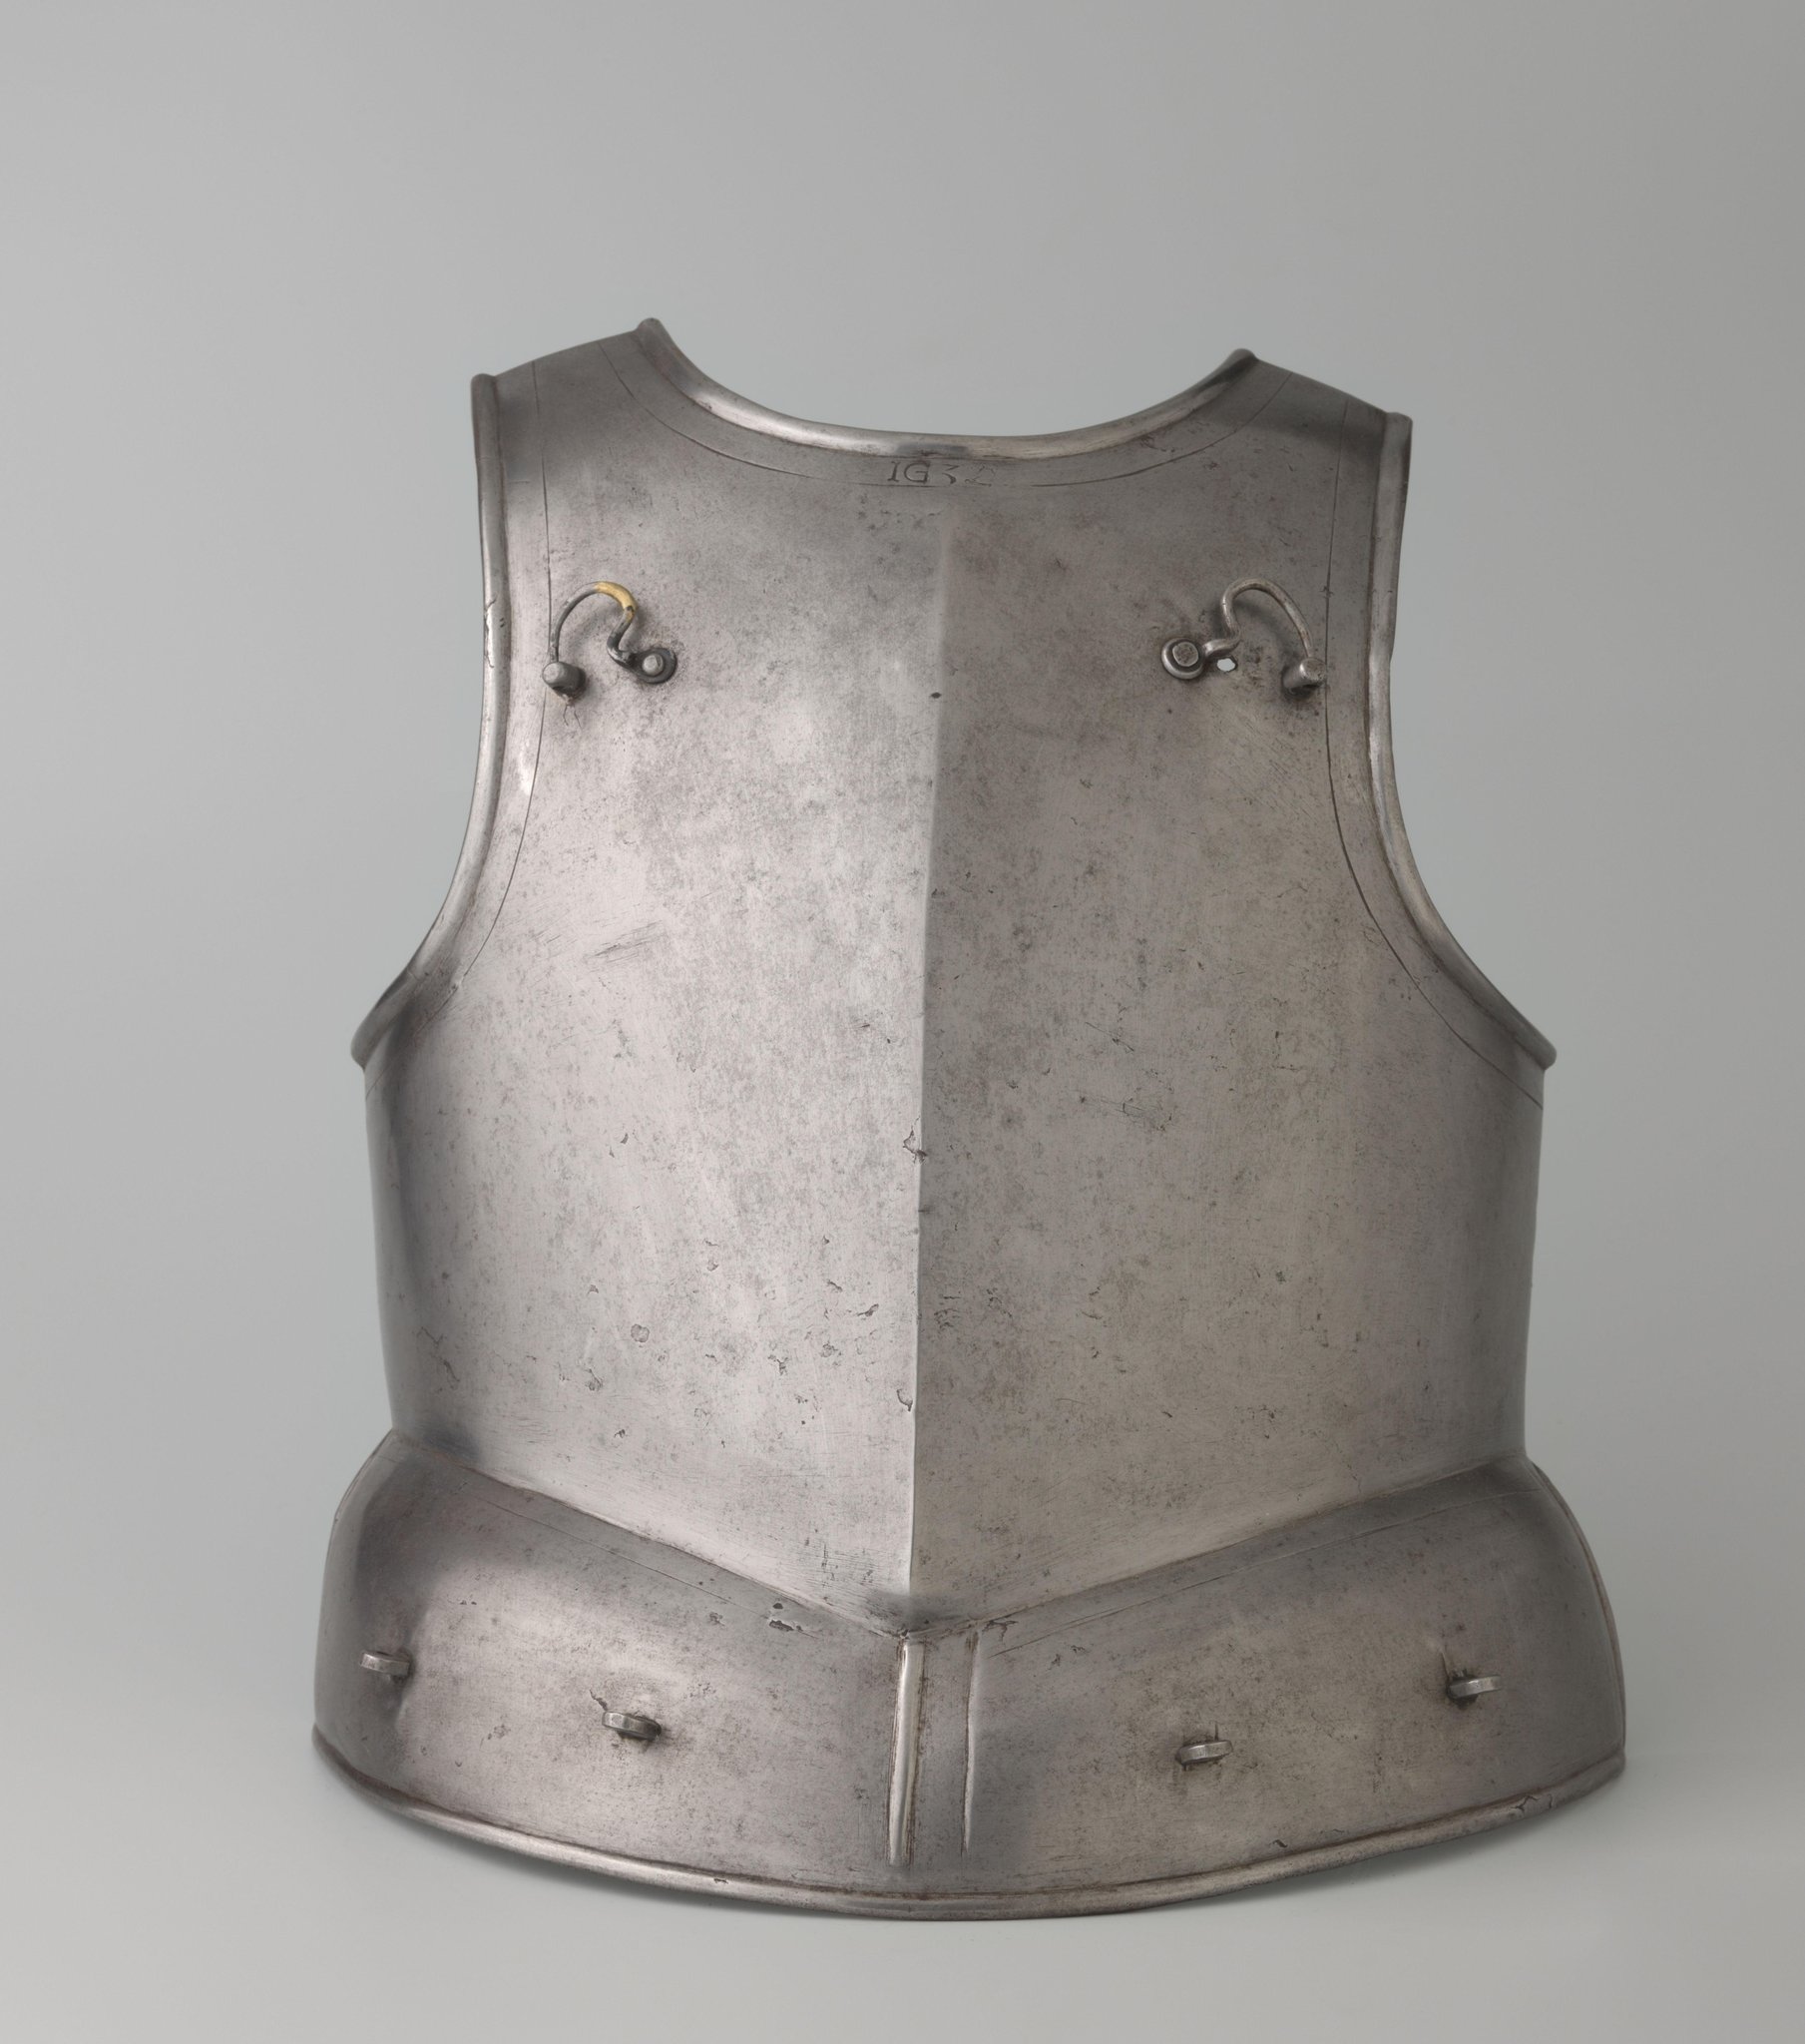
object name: breastplate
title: Borstplaat van kuras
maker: Anonymous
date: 1599-1699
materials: iron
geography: netherlands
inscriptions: : ‘IG 32’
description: Borstplaat, ijzer, blank, de arm- en halsuitsnijdingen alsmede onder- en achterrand van de buikkraag rondgeflenst. Decoratielijnen aangebracht parallel lopend aan de omgeflenste randen van de borstplaat. Ter hoogte van de armuitsnijdingen twee draaibare haken met knoppen waar de schouderriemen aan bevestigd kunnen worden. De linkerhaak is deels koperkleurig. In het centrum van de borstplaat een verticale middengraat die van de halsuitsnijding naar beneden loopt en eindigt in een kleine uitstulping vlak boven de buikkraag. Vrij brede buikkraag en is in het midden zijn twee delen over elkaar gevouwen. Op de buikkraag vier knoppen met ronde gaten waar de dijbeenplaten aan bevestigd kunnen worden. Bovenaan in het midden tussen de decoratielijn en de rand staat IG32 .Binnenzijde is zwart geverfd, aan rechterzijde een nieuw ingebrachte blanke klinknagel. In het midden het merk van de stad Amsterdam.